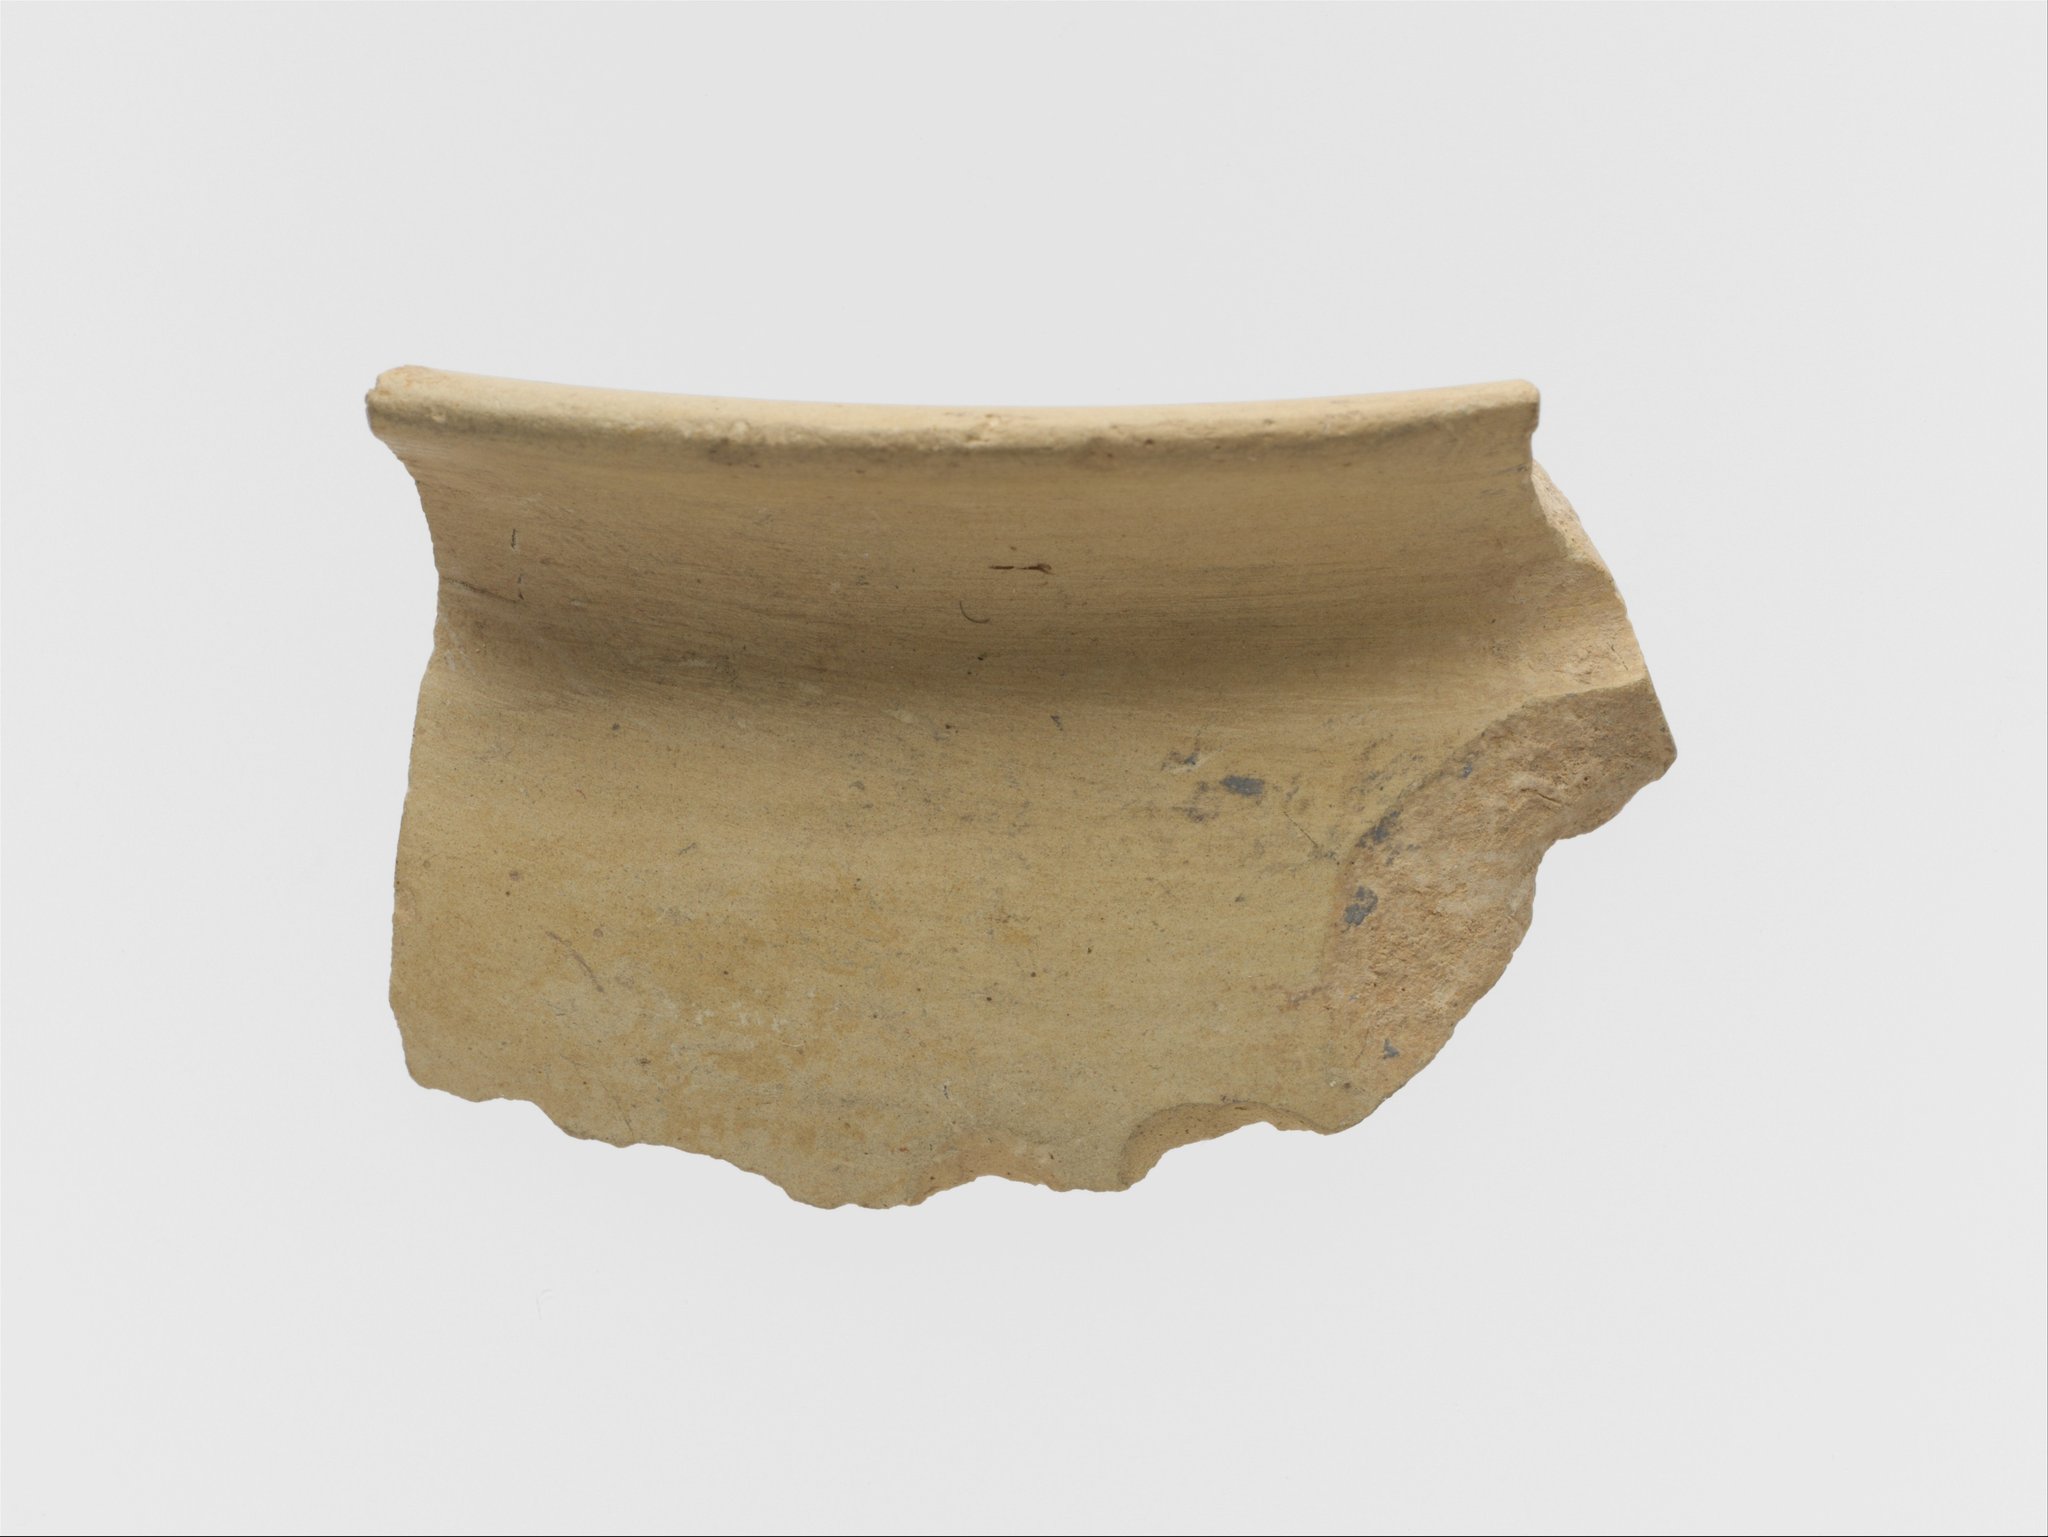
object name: vase fragment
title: Terracotta rim of a vase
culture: helladic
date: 2000-1600 BCE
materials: terracotta